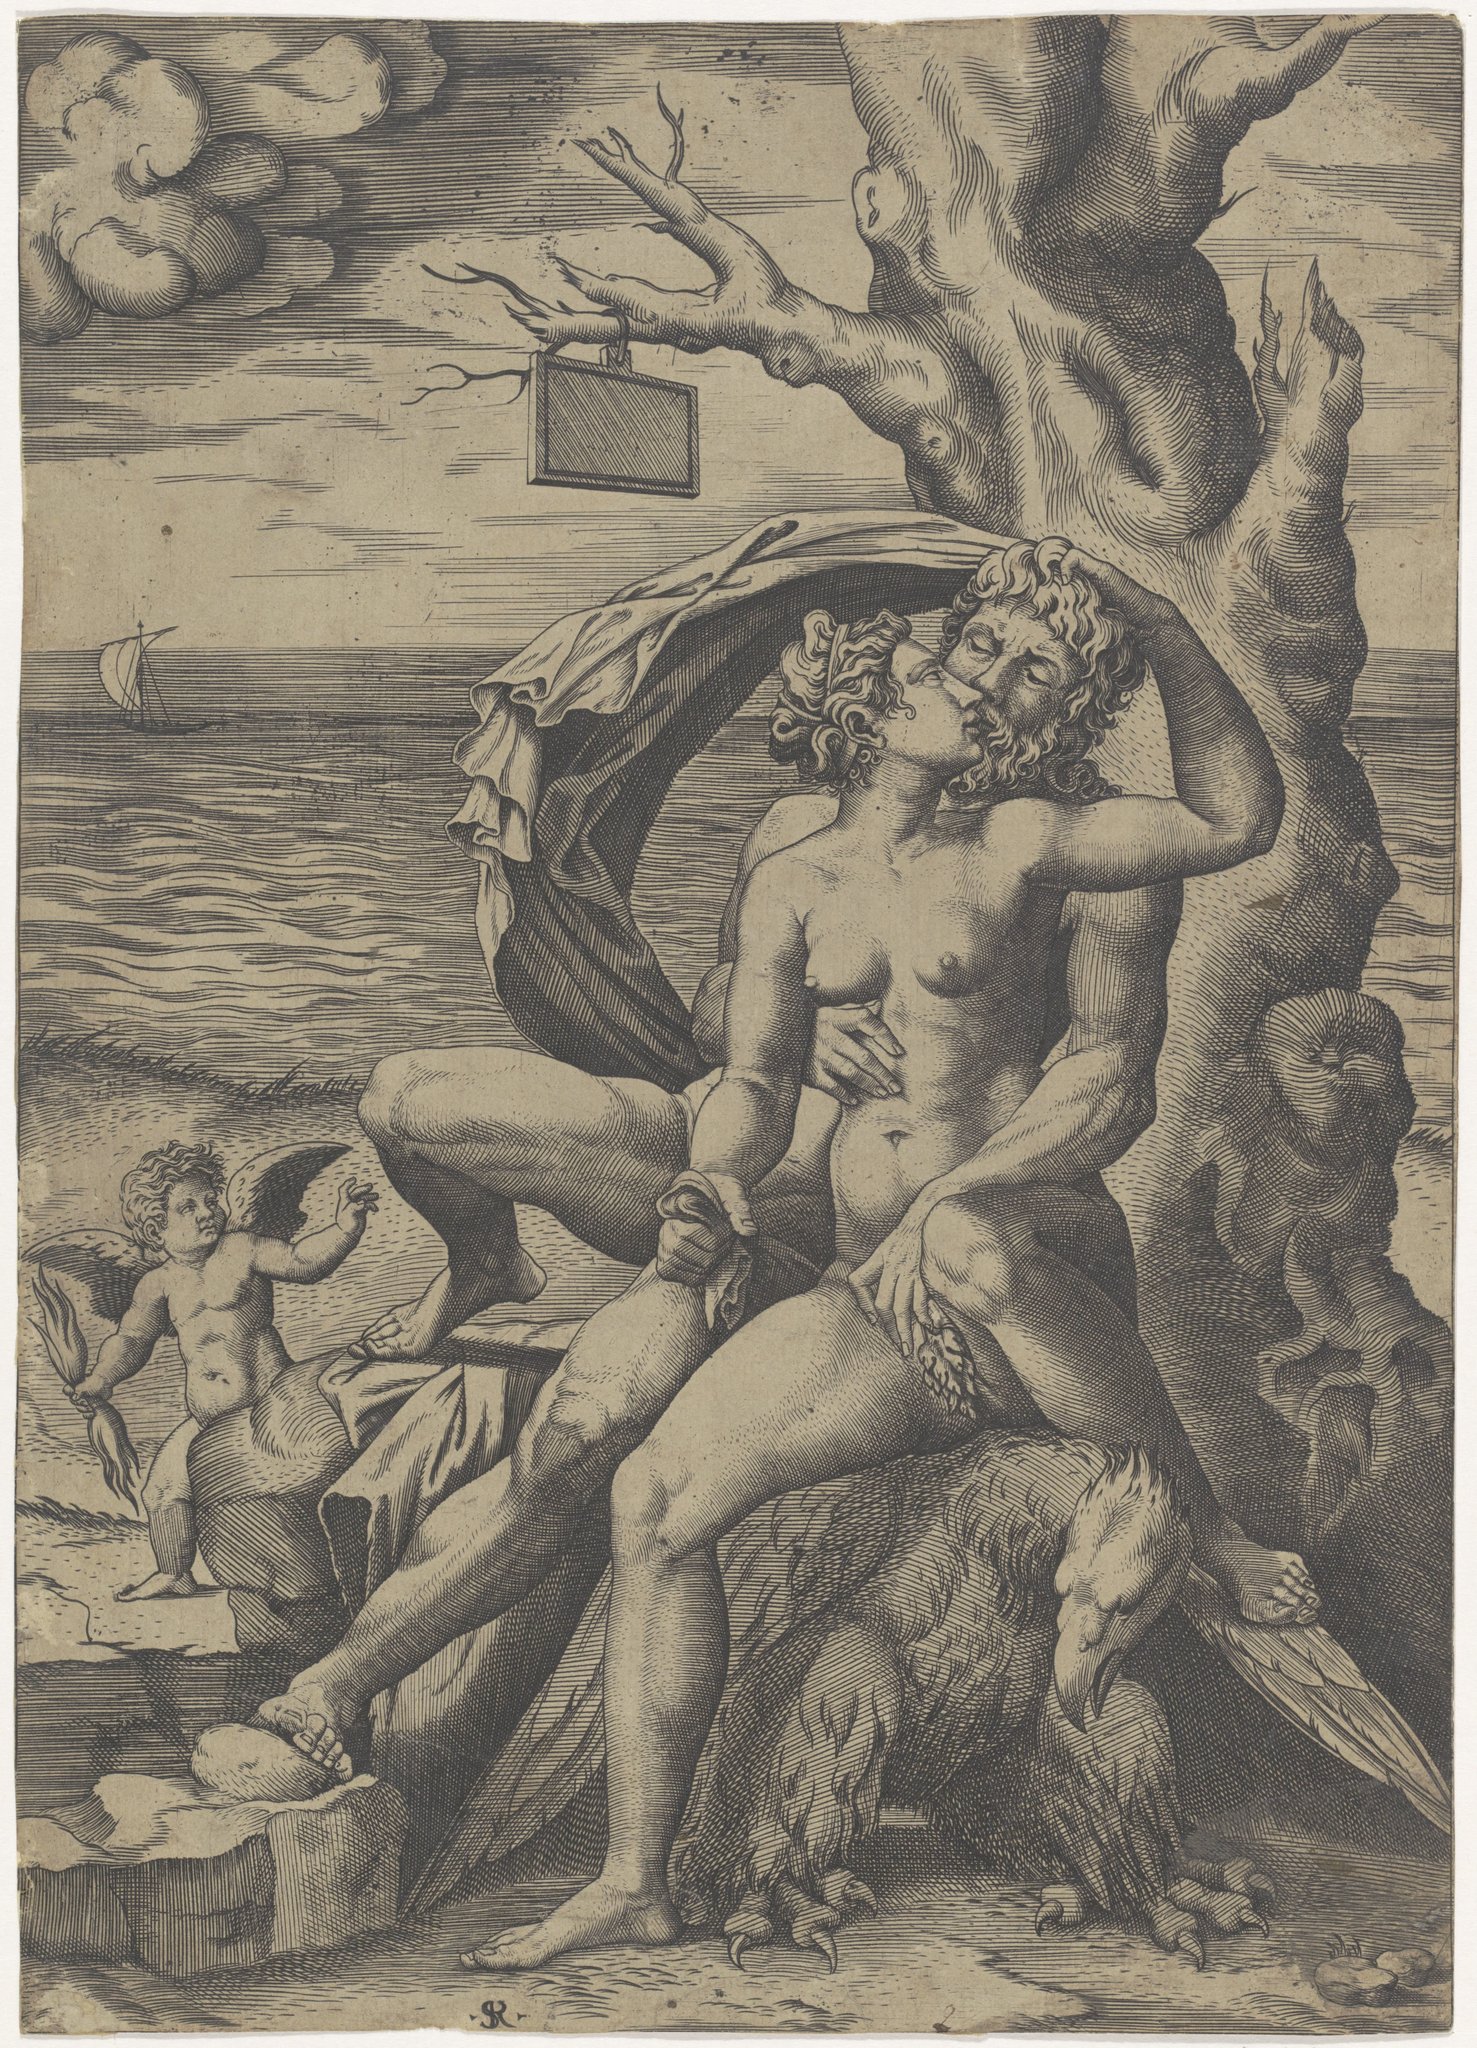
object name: print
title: Jupiter en Semele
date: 1510-1527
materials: paper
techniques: engraving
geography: italy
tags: jupiter wooing semele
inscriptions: collector's mark: Lugt 10, collector's mark: Lugt 11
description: Jupiter bemint Semele aan de voet van een boom. Ze zitten beiden op Jupiters adelaar. Links Amor met de bliksemschicht van Jupiter. Op de achtergrond de zee.